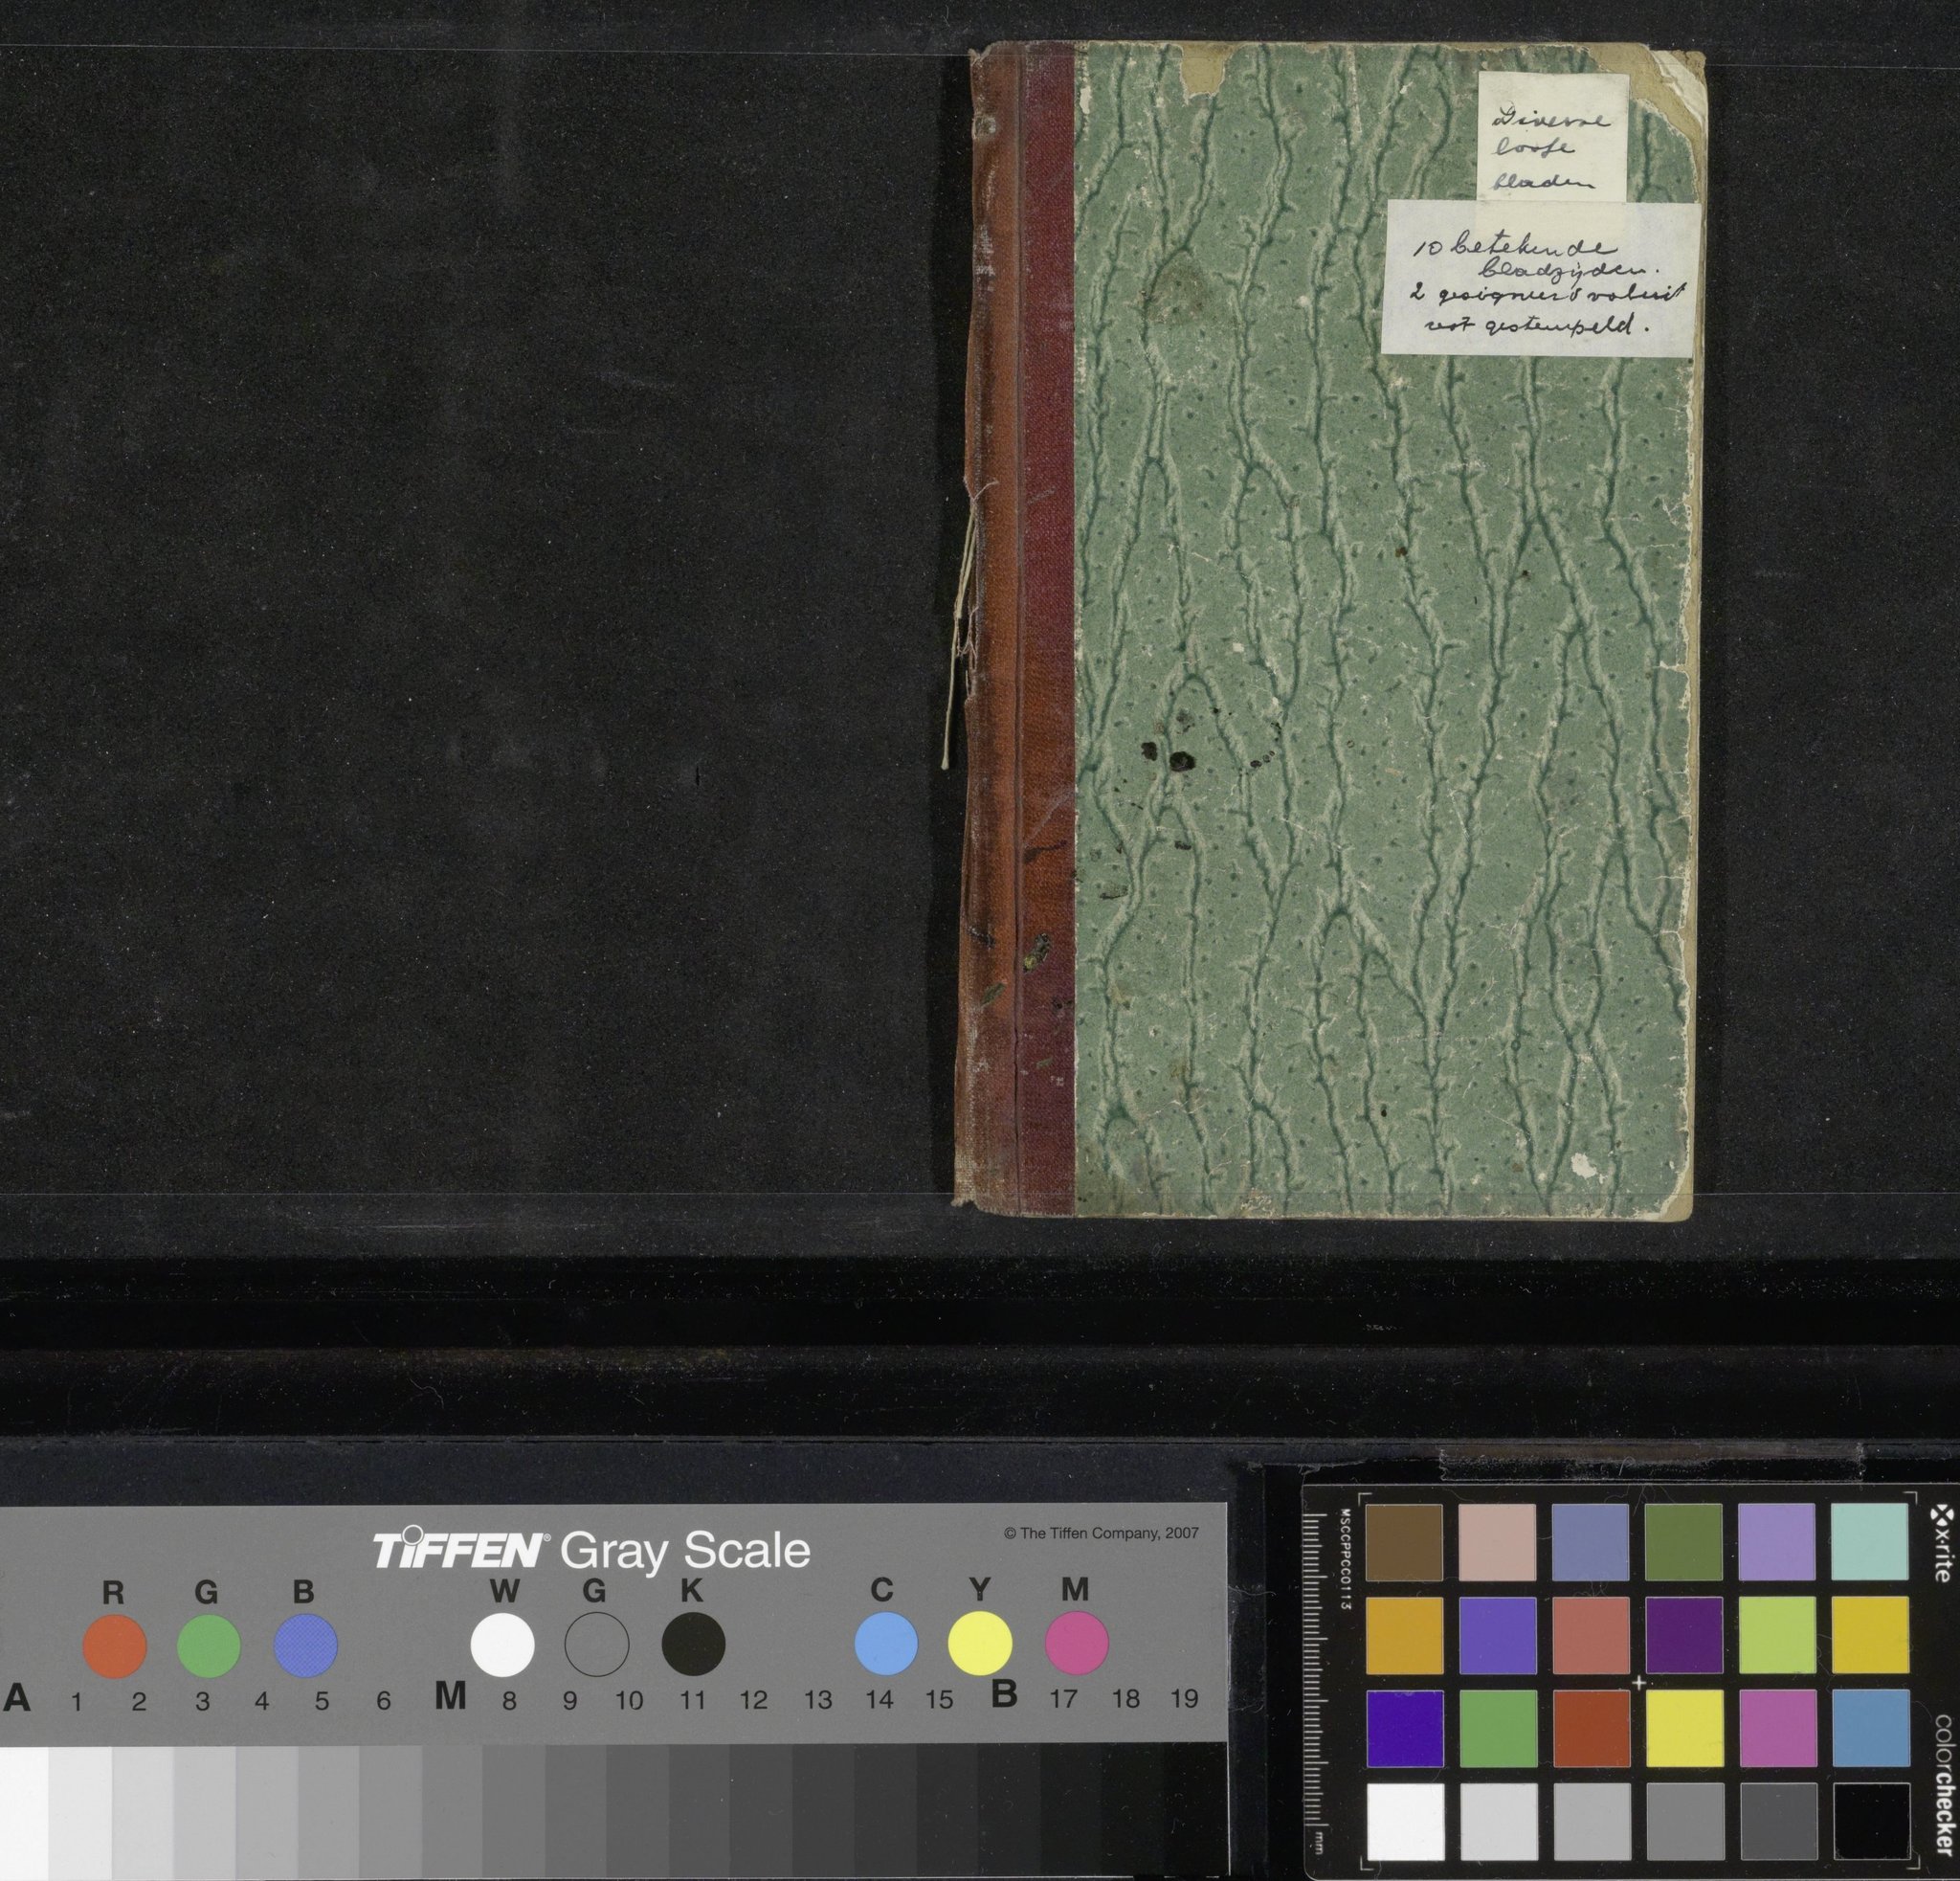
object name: sketchbook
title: Leeg groen schetsboekbandje met rode linnen boekrug waarin voorheen 10 losse bladen hebben gezeten volgens het opschift op de voorkant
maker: george hendrik breitner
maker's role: draughtsman, painter, print maker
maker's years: 1857-1923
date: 1867-1923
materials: chalk, paper, pencil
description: Leeg groen schetsboekbandje met rode linnen boekrug waarin voorheen 10 losse bladen hebben gezeten volgens het opschrift op de voorkant. Opgeborgen samen met 12 andere schetsboekjes in een bruine doos 'Breitner II'.